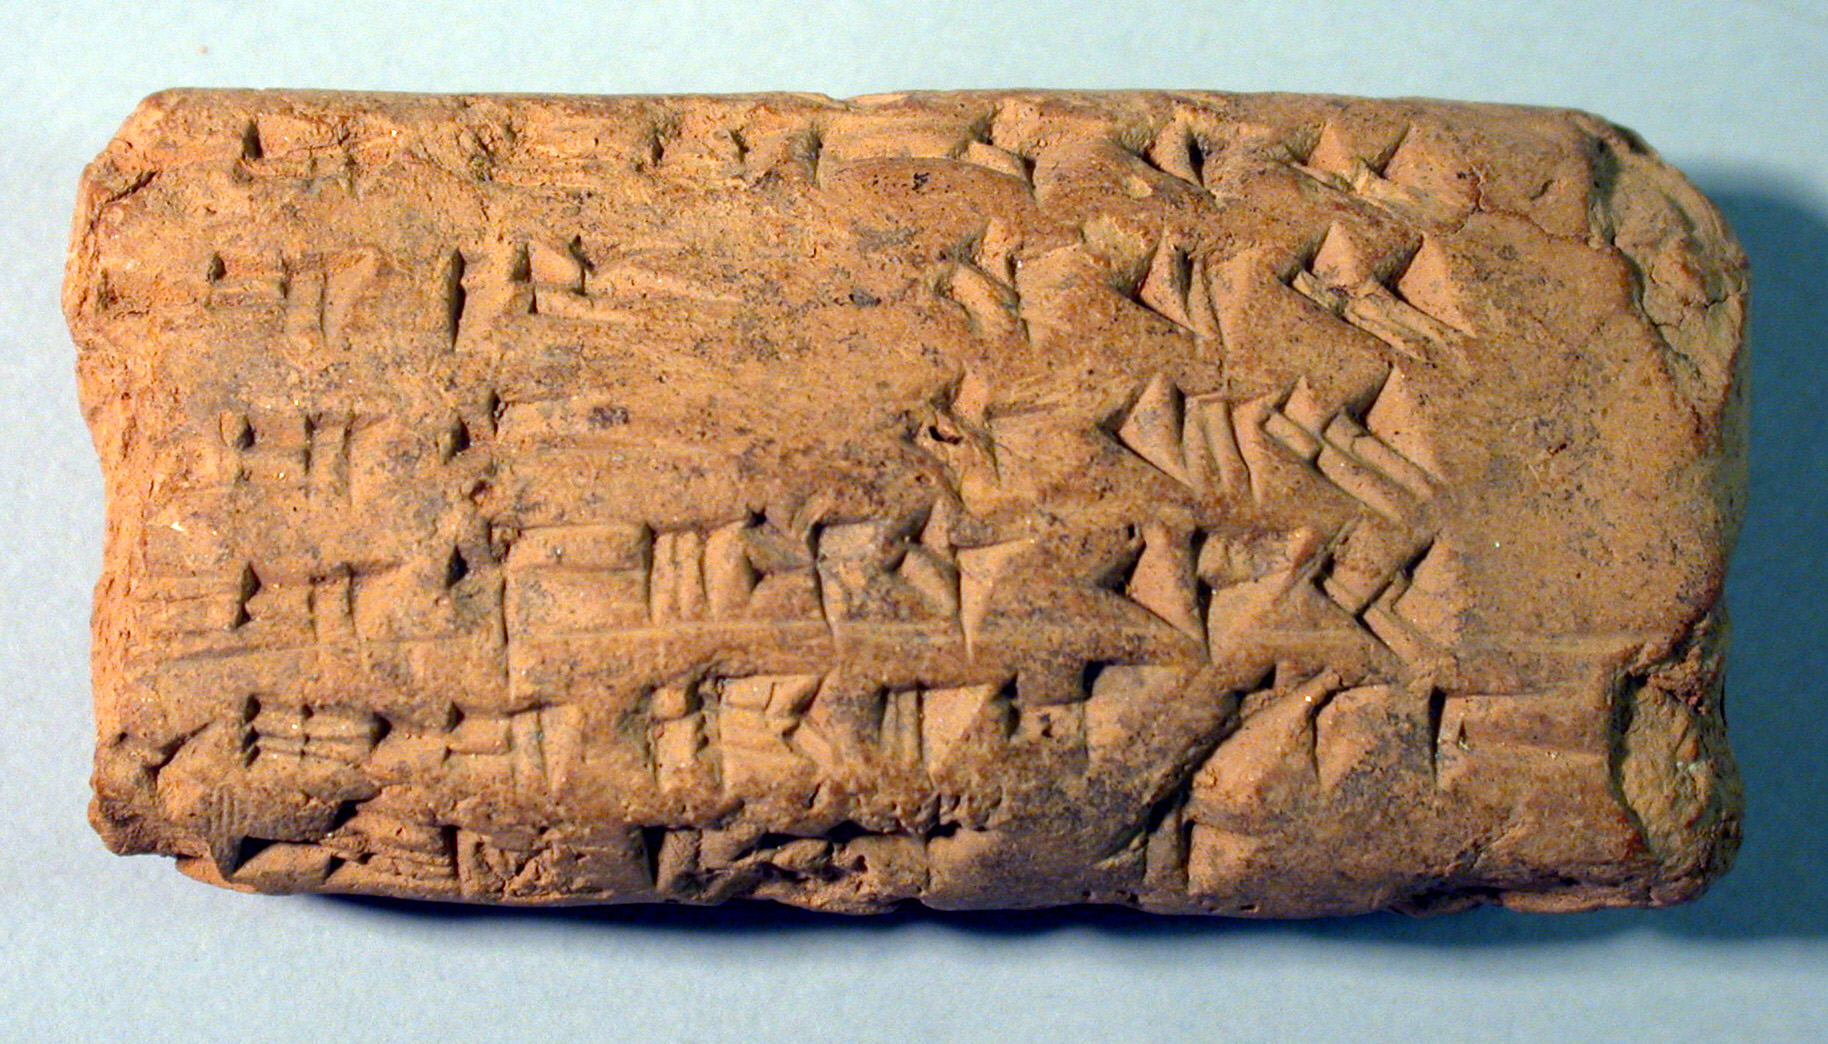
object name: cuneiform tablet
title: Cuneiform tablet: flour deliveries for rent payment, Ebabbar archive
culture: babylonian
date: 700-501 BCE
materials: clay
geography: mesopotamia